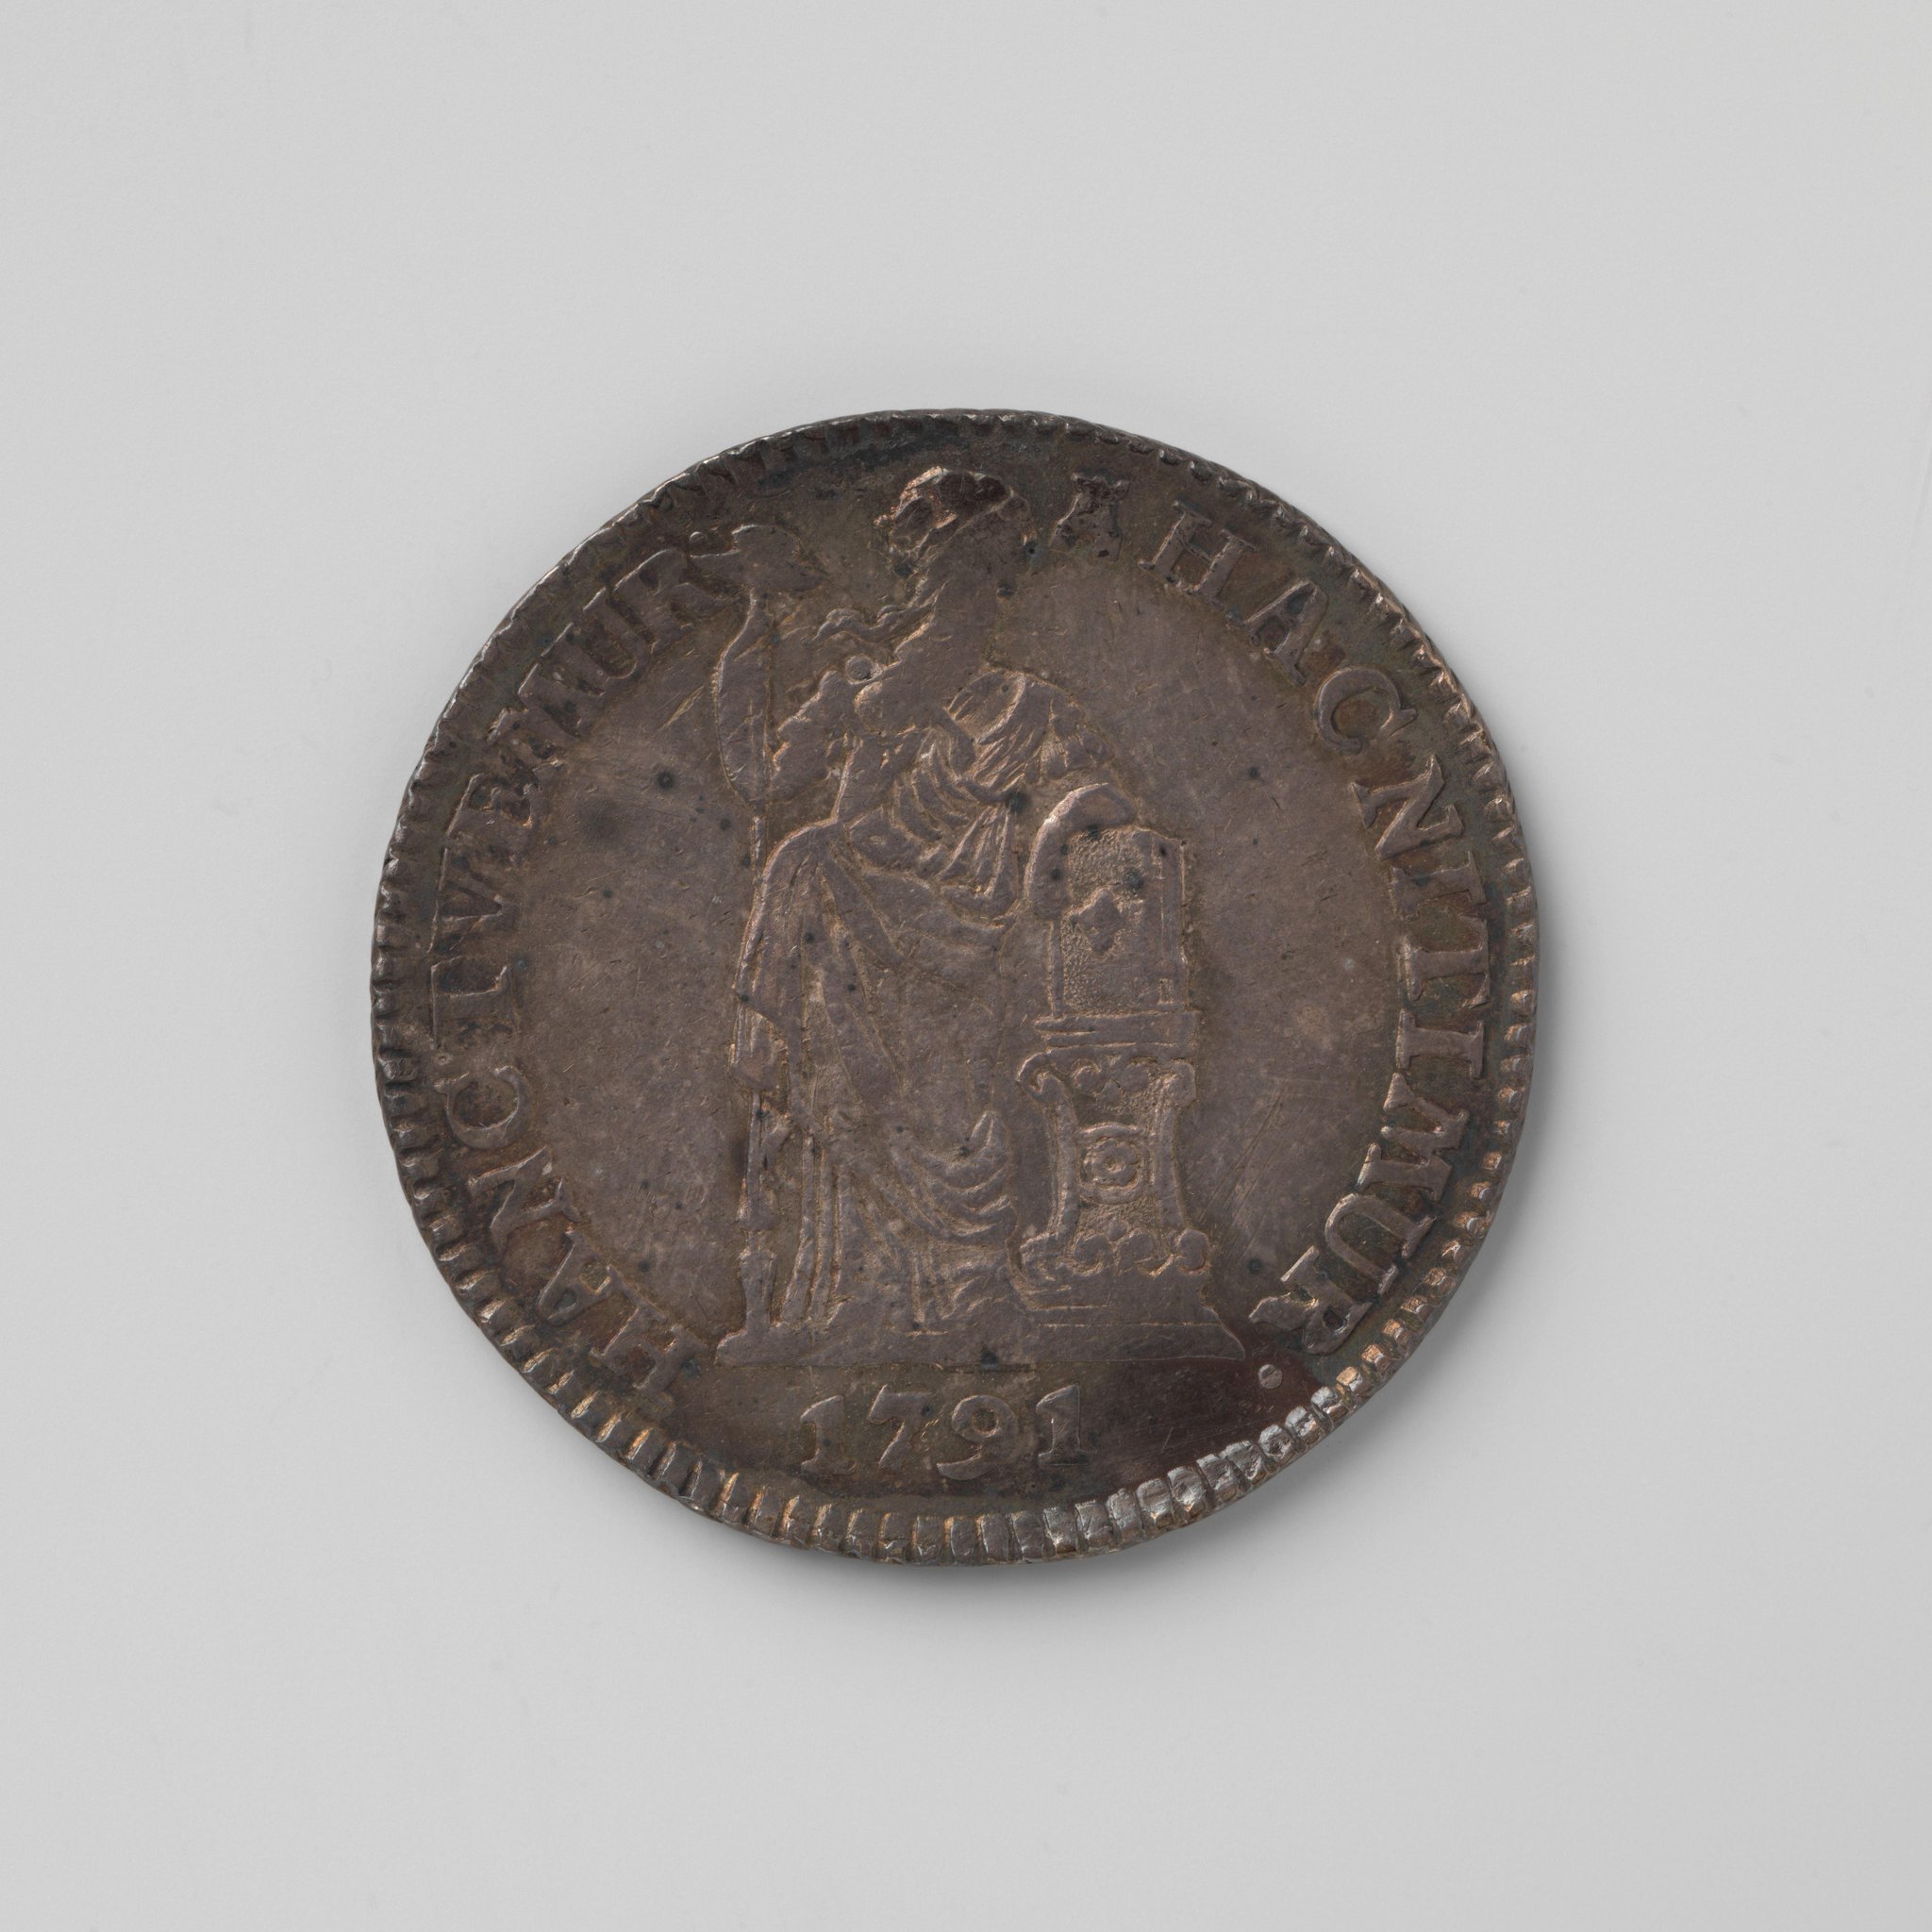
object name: coin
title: VOC, gulden, Zeeland, 1791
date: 1791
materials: silver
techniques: striking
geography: middelburg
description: Zilveren munt. Voorzijde: tussen waarde-aanduiding I Gl. gekroond generaliteitswapenschild, waaronder cartouche, waarin monogram van de VOC. Keerzijde: Nederlandse maagd met speer, waarop vrijheidshoed, leunend op een bijbel op een altaar. Jaartal in afsnede. Kabelrand.